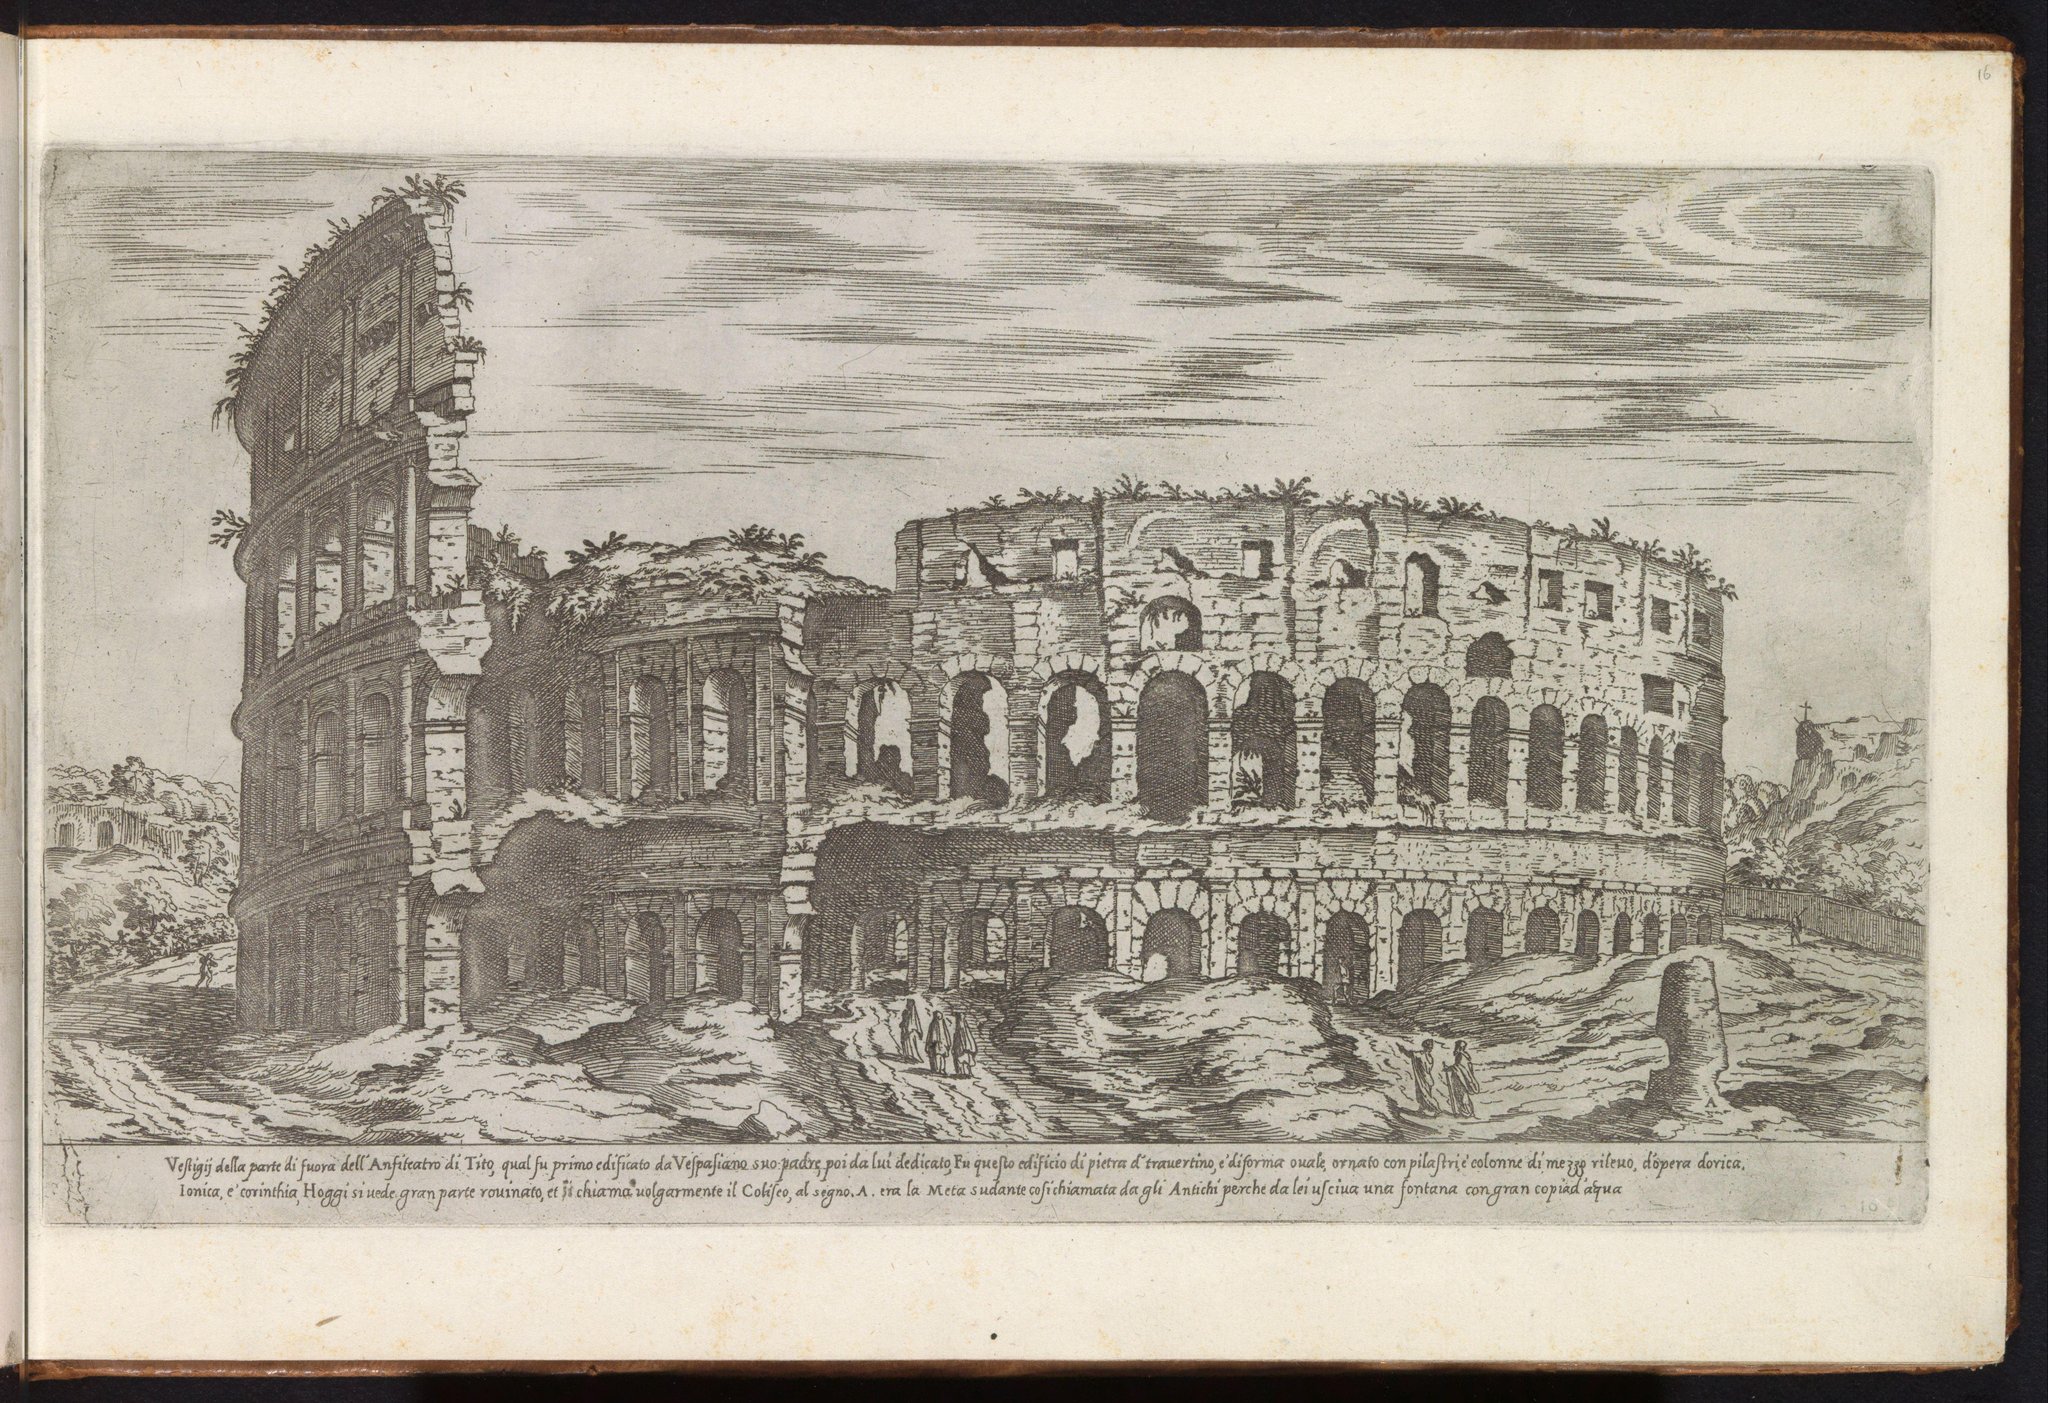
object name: print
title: Colosseum te Rome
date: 1575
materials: paper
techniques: engraving, etching, intaglio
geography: vatican city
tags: city-view, and landscape with man-made constructions, ruin of a building ~ architecture, landscape with ruins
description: Gezicht op het Colosseum te Rome. Onderschrift in het Italiaans. Prent maakt deel uit van een album.